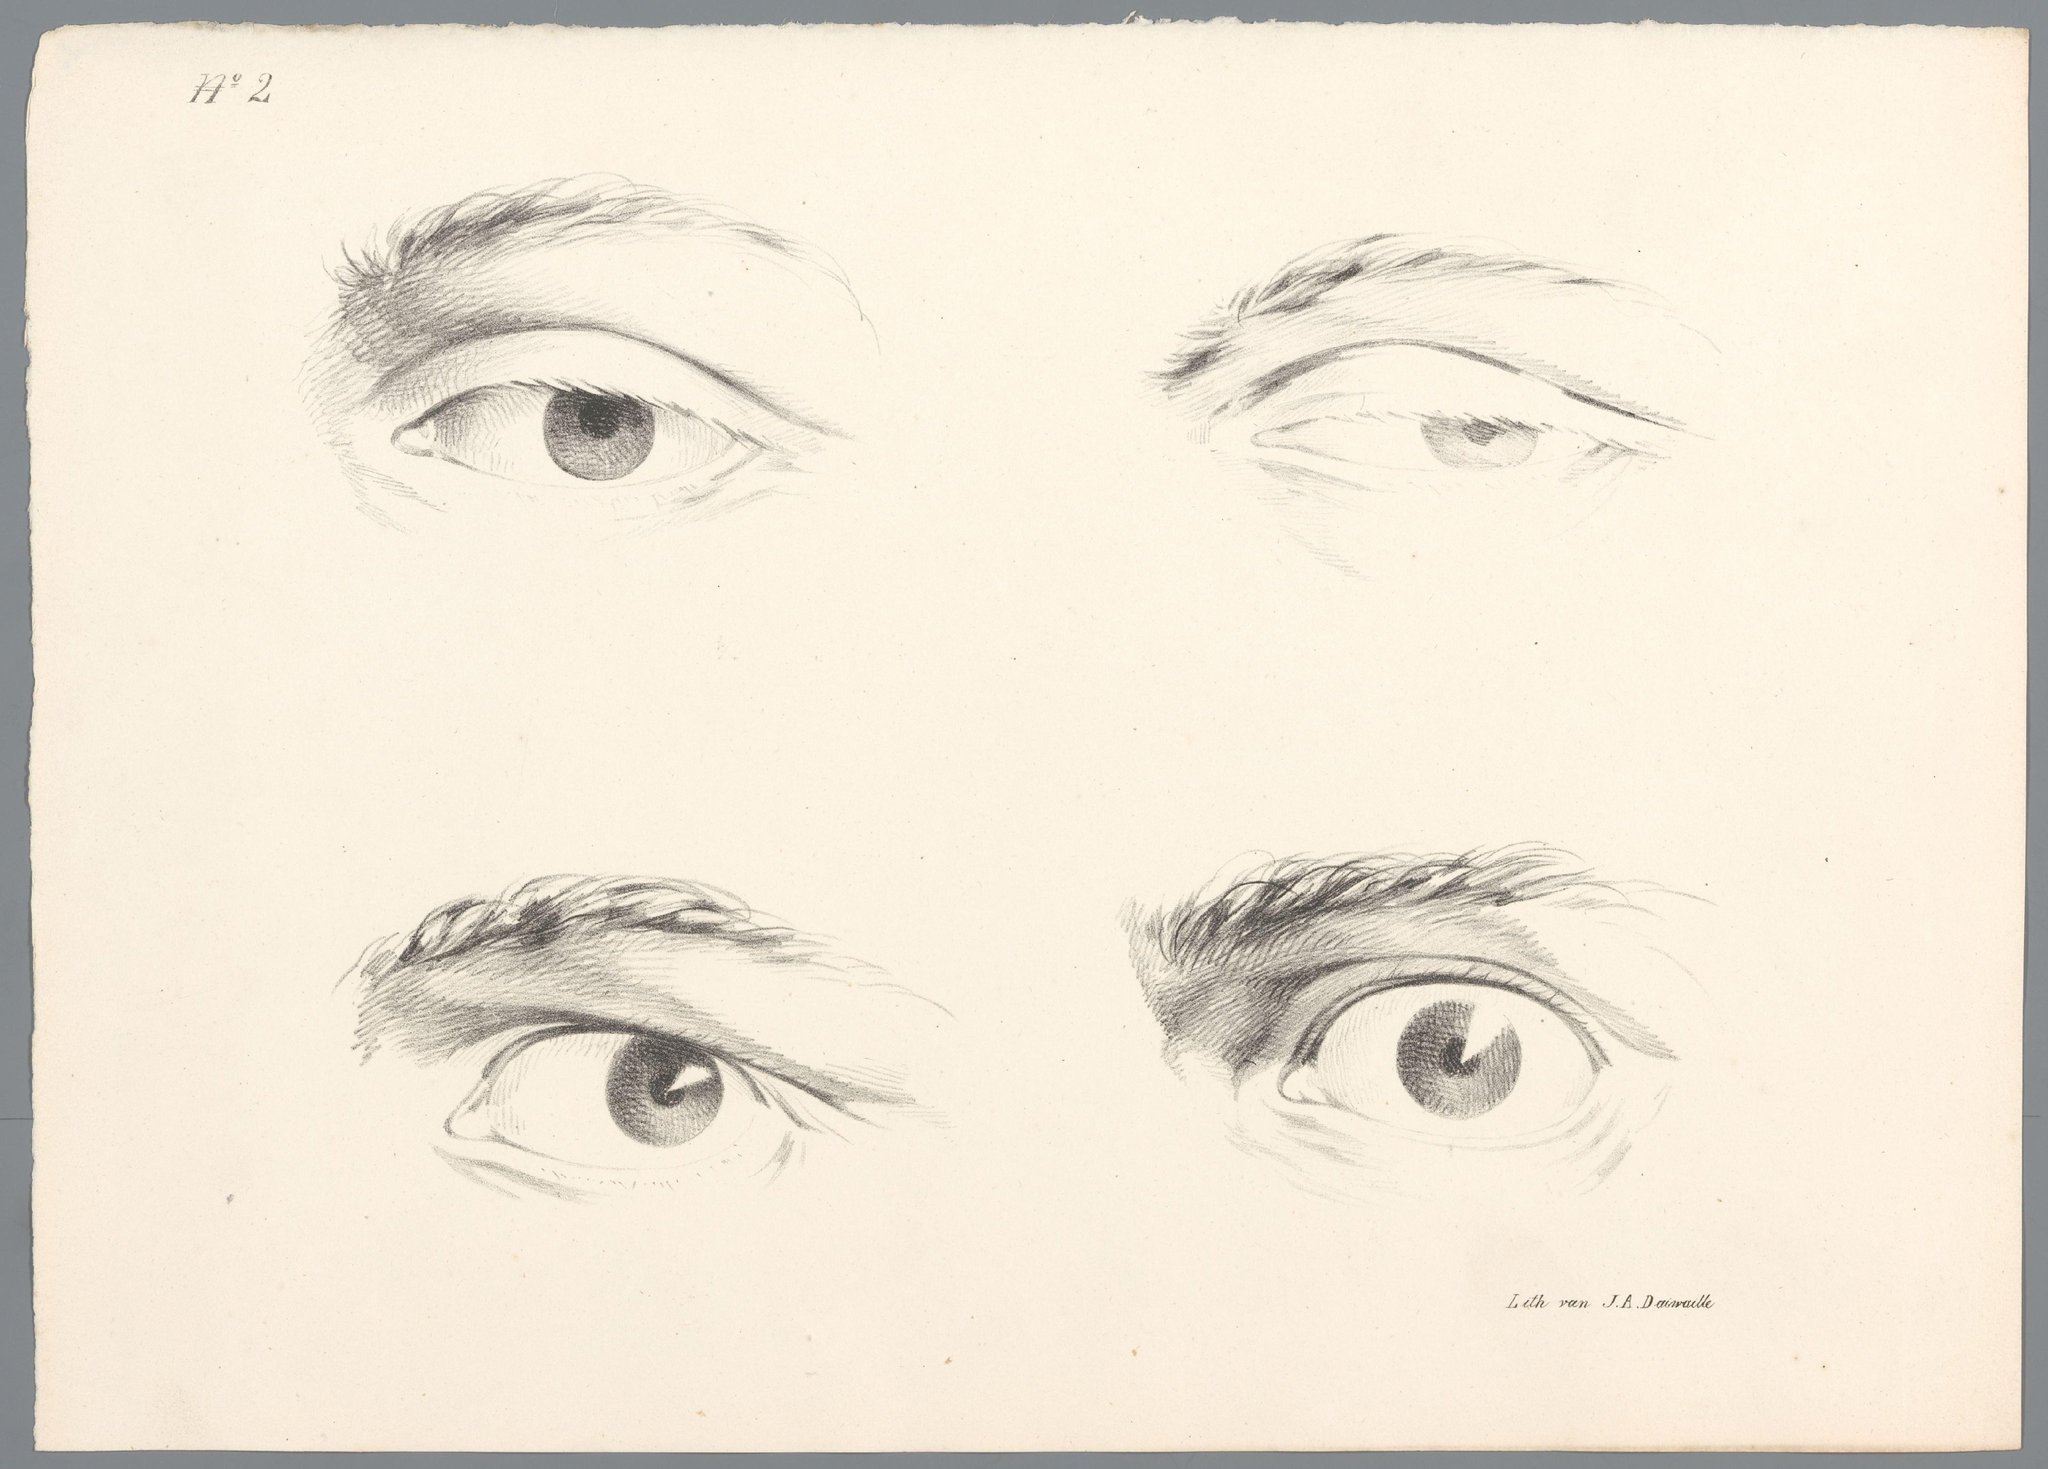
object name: print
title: Vier ogen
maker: jean augustin daiwaille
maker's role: draughtsman, print maker, printer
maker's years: 1786-1850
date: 1820-1826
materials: paper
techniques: lithograph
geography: amsterdam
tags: eyes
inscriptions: collector's mark: Lugt 2228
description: De bovenste twee ogen hebben laaghangende oogleden. De onderste twee ogen zijn verder open. Het oog rechtsonder is ver opengesperd. Genummerd linksboven: 'No. 2'. Deze prent maakt deel uit van een omslag met veertien prenten.